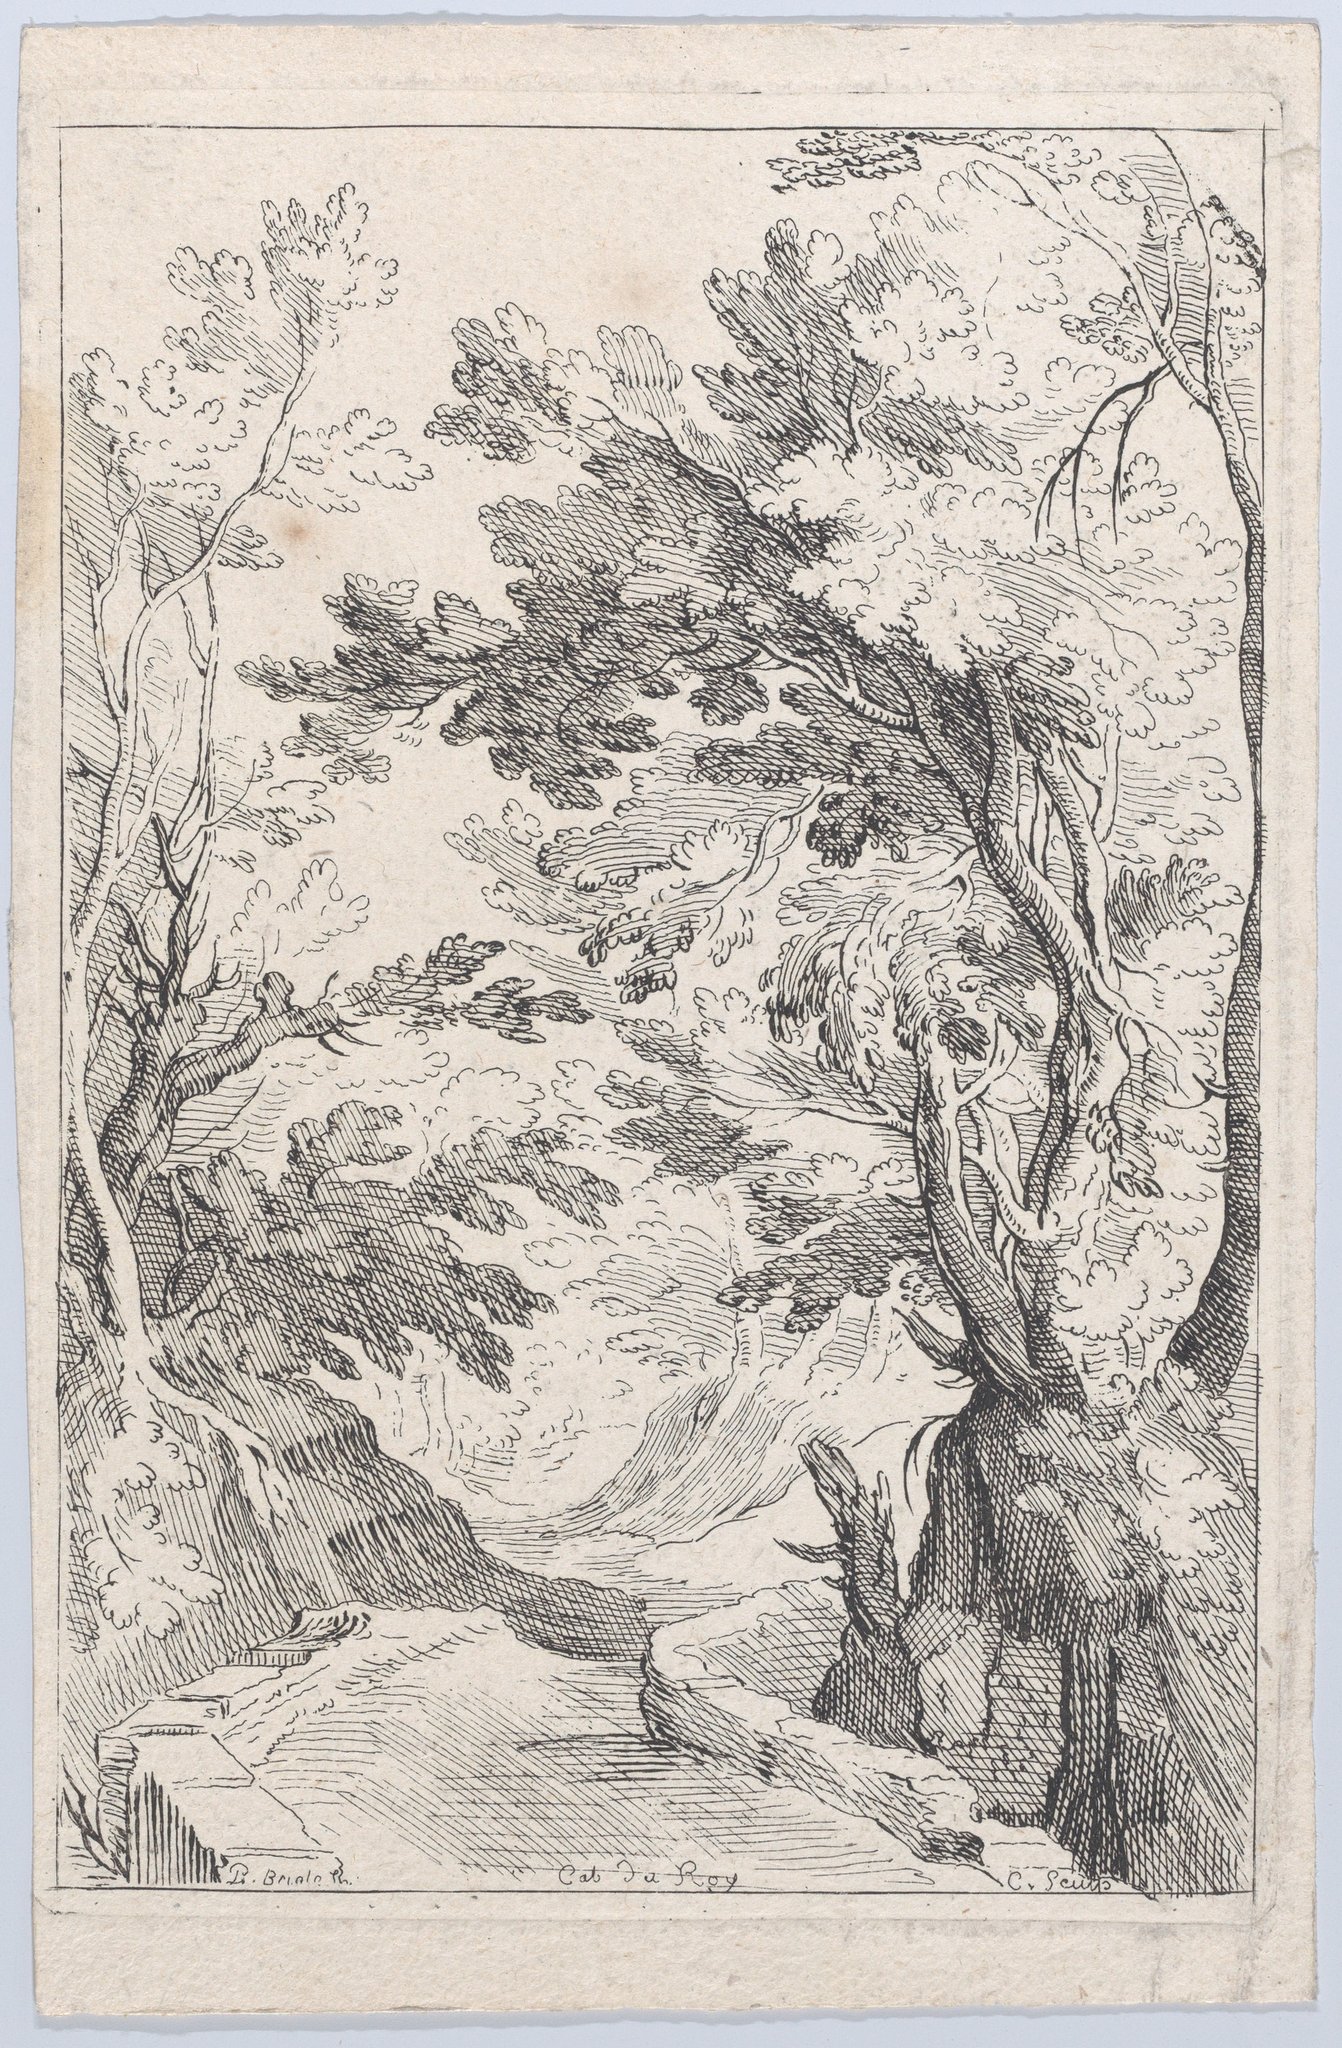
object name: print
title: A Pathway with a Parapet in a Forest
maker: anne claude philippe de tubières, comte de caylus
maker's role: artist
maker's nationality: french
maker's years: 1692-1765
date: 1701-1800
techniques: etching